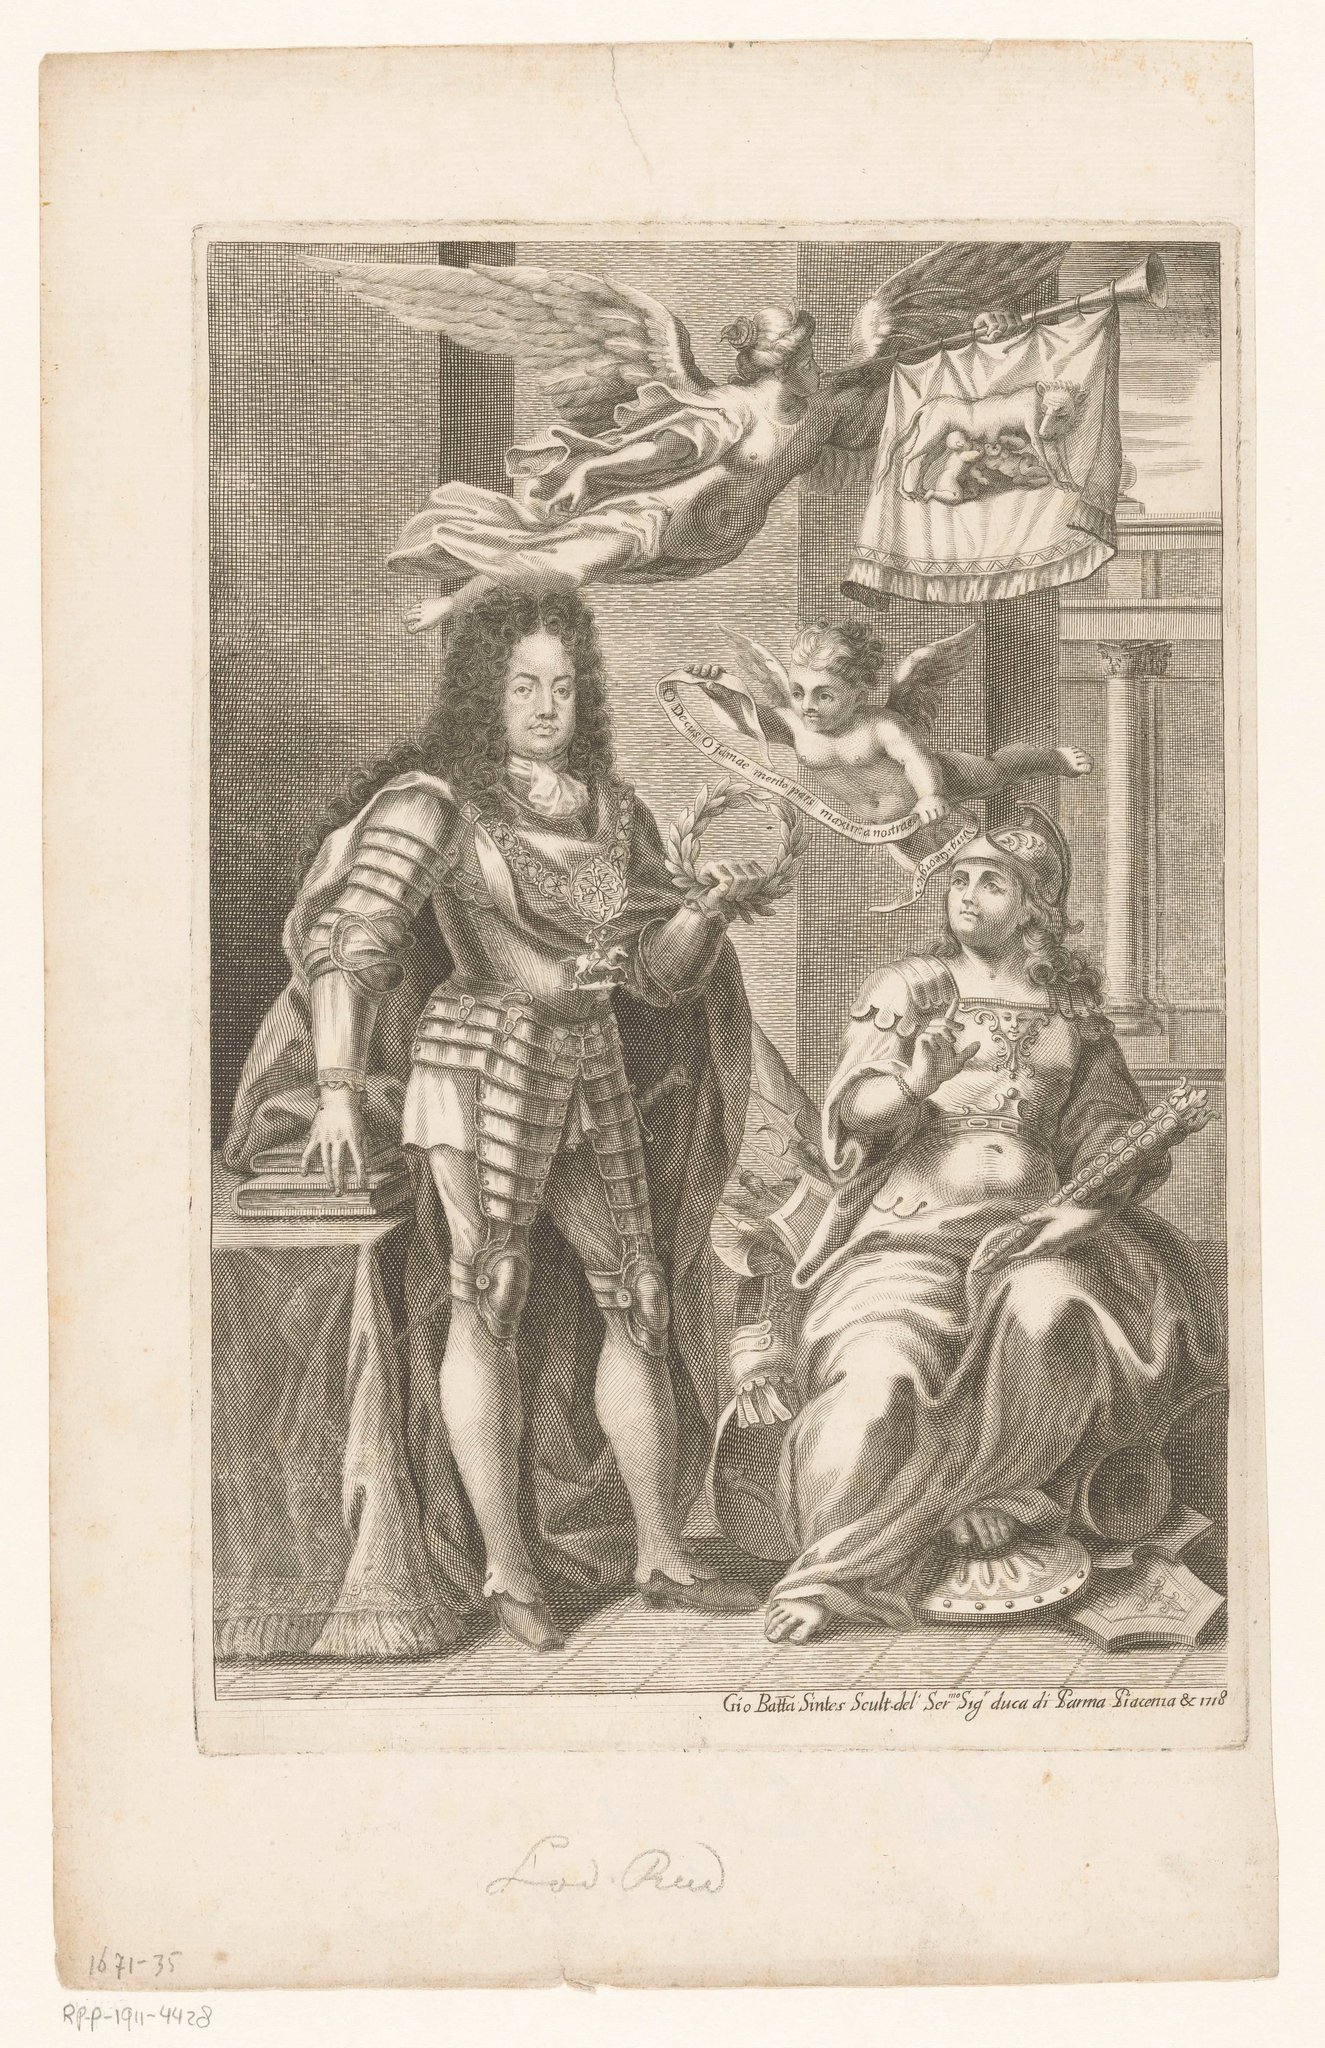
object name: print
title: Allegorische voorstelling met man in wapenrusting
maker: giovanni battista sintes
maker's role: print maker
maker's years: 1680-1760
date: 1700-1749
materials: paper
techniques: engraving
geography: italy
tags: romulus and remus are washed ashore and suckled by a she-wolf; 'lupa romana', horn, trumpet, cornet, trombone, tuba, historical persons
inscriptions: collector's mark: Lugt 2228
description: Een man gekleed in wapenrusting, mogelijk Lodewijk Rudolf van Brunswijk-Wolfenbüttel. Rechts een zittende vrouw met oorlogsattributen. Boven hen blaast een engel op een trompet, waaraan een doek hangt met een afbeelding van Romulus en Remus met de zogende wolvin.